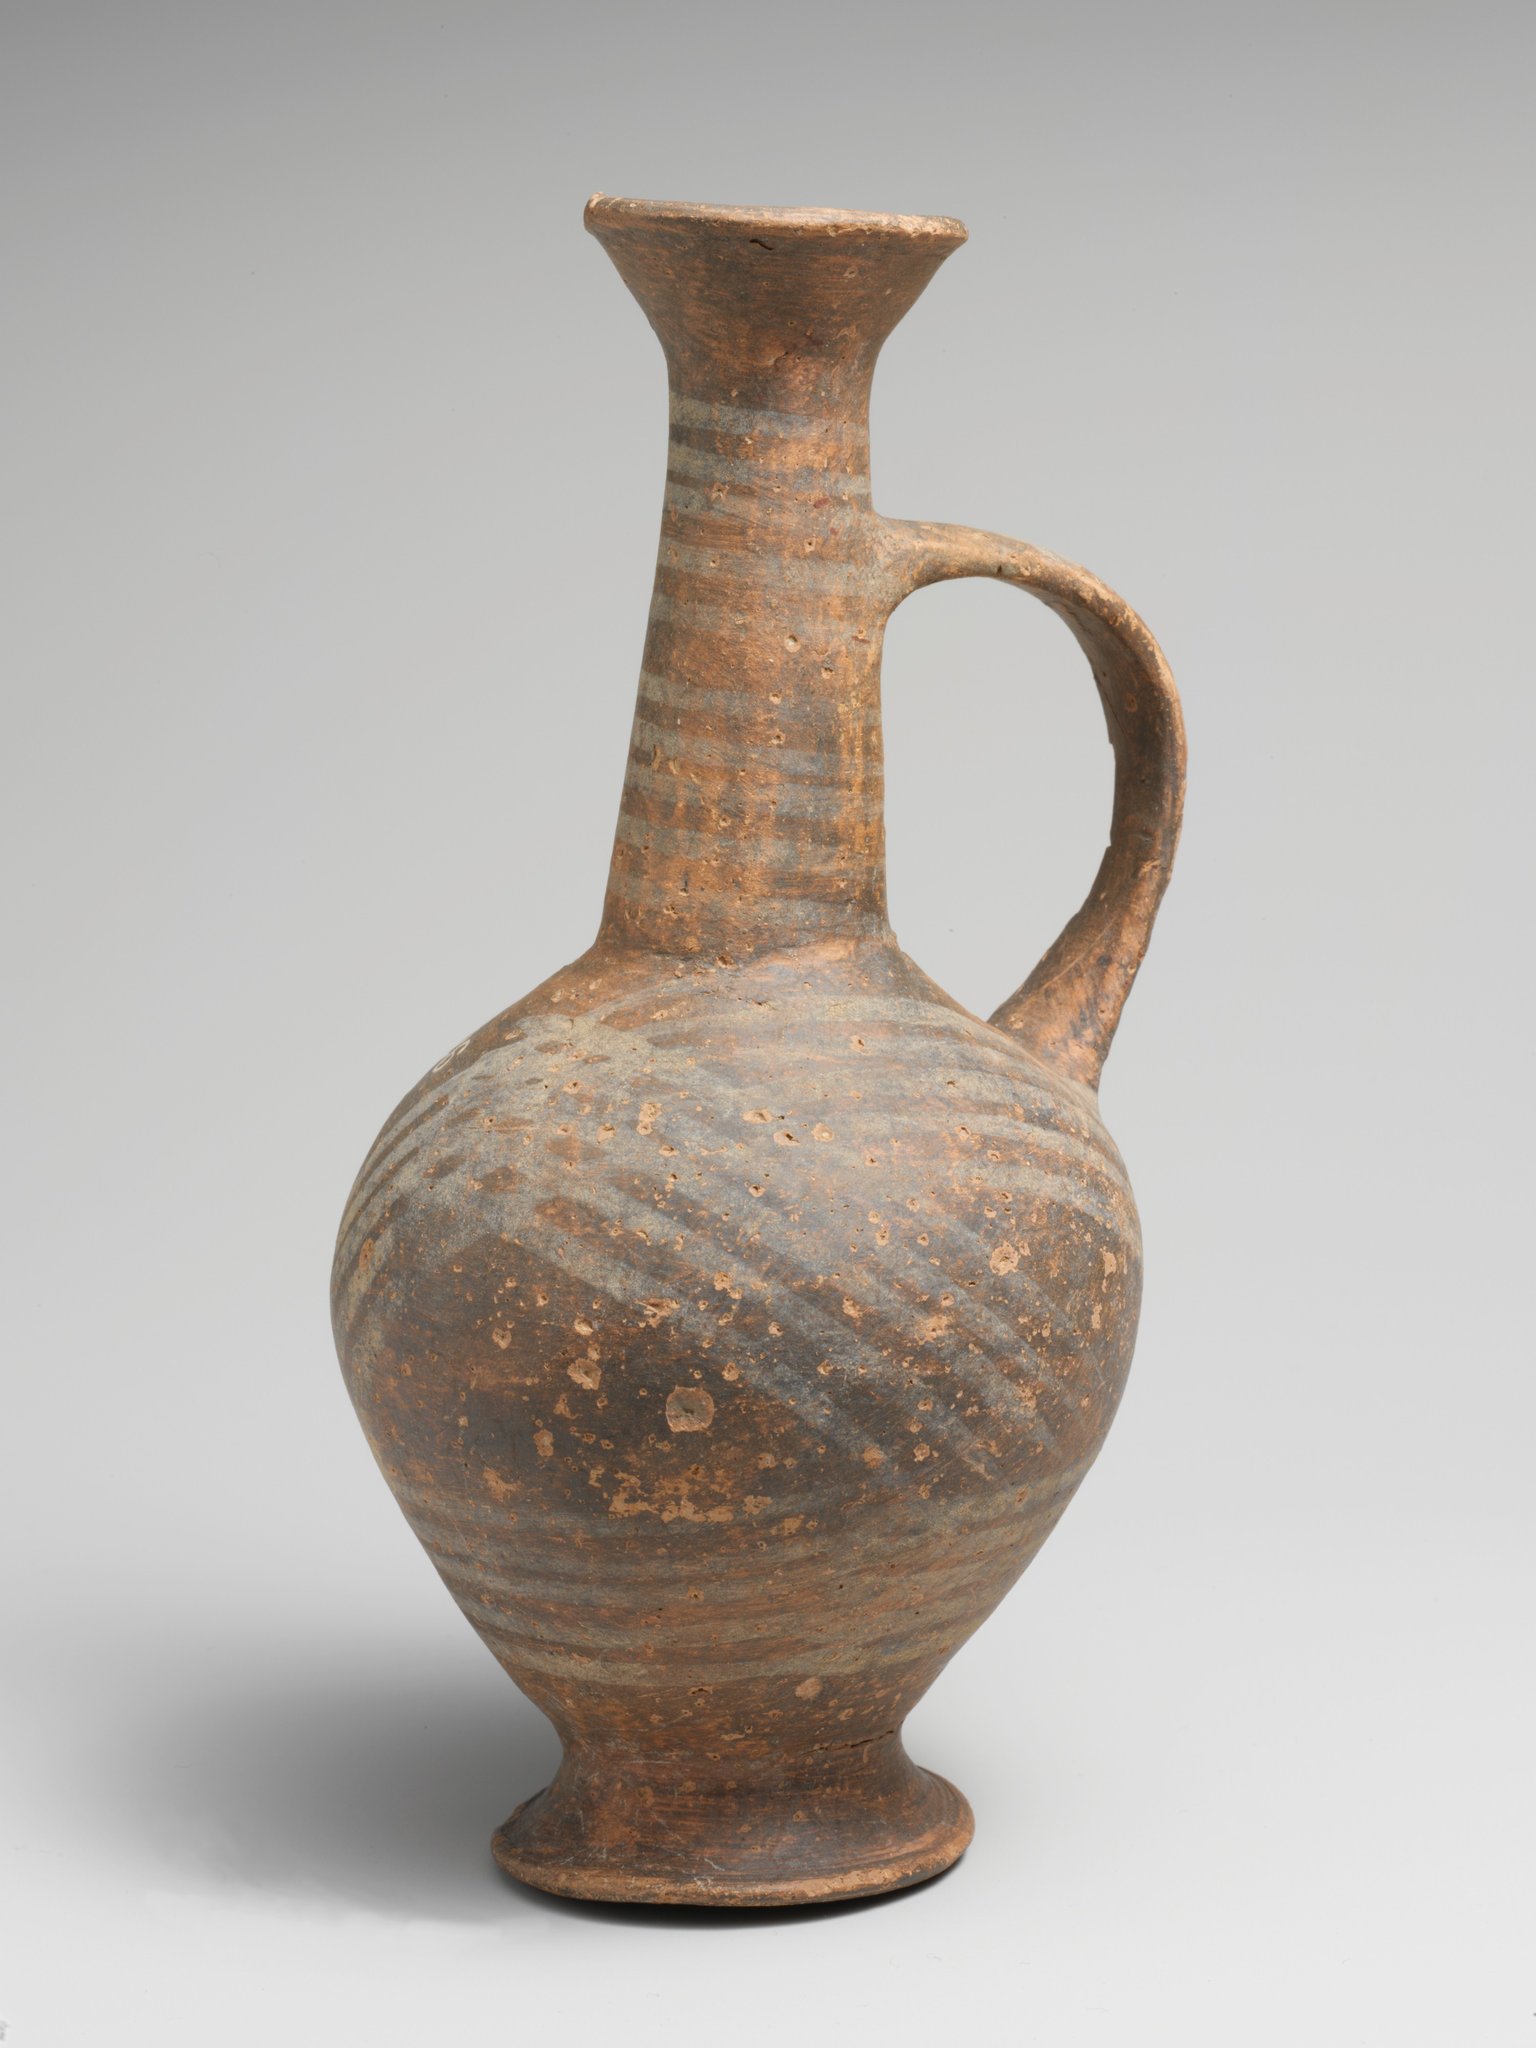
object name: jug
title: Terracotta jug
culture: cypriot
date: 1450-1200 BCE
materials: terracotta